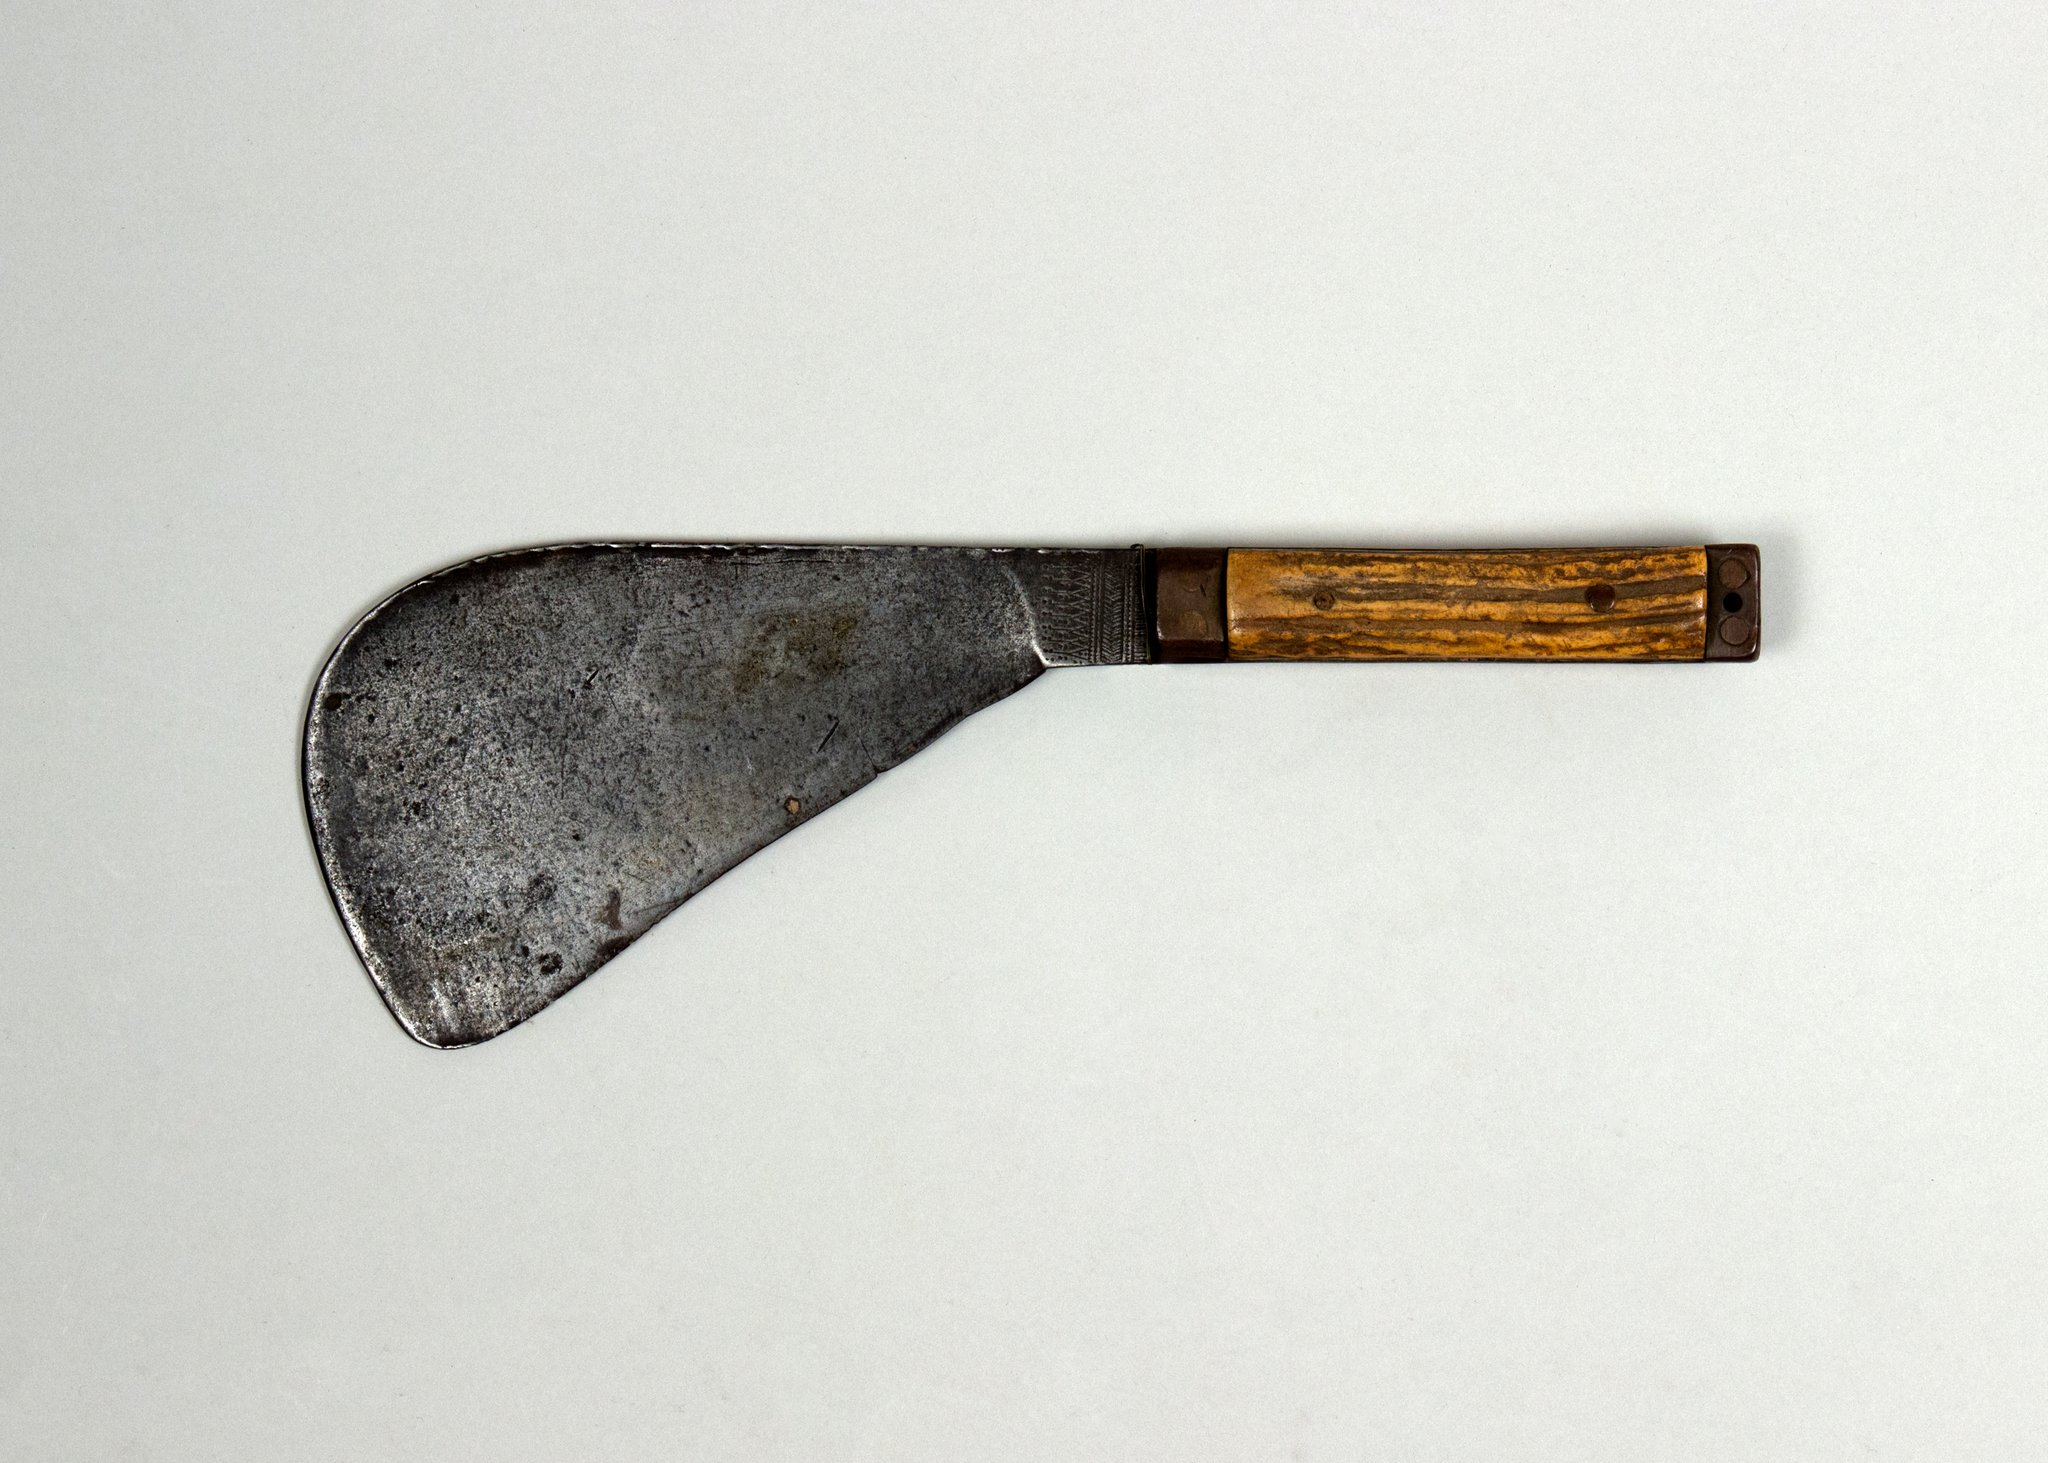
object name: sword ayda katti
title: Sword (Ayda Katti)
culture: indian, coorg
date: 1801-1900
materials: brass, horn, steel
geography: india